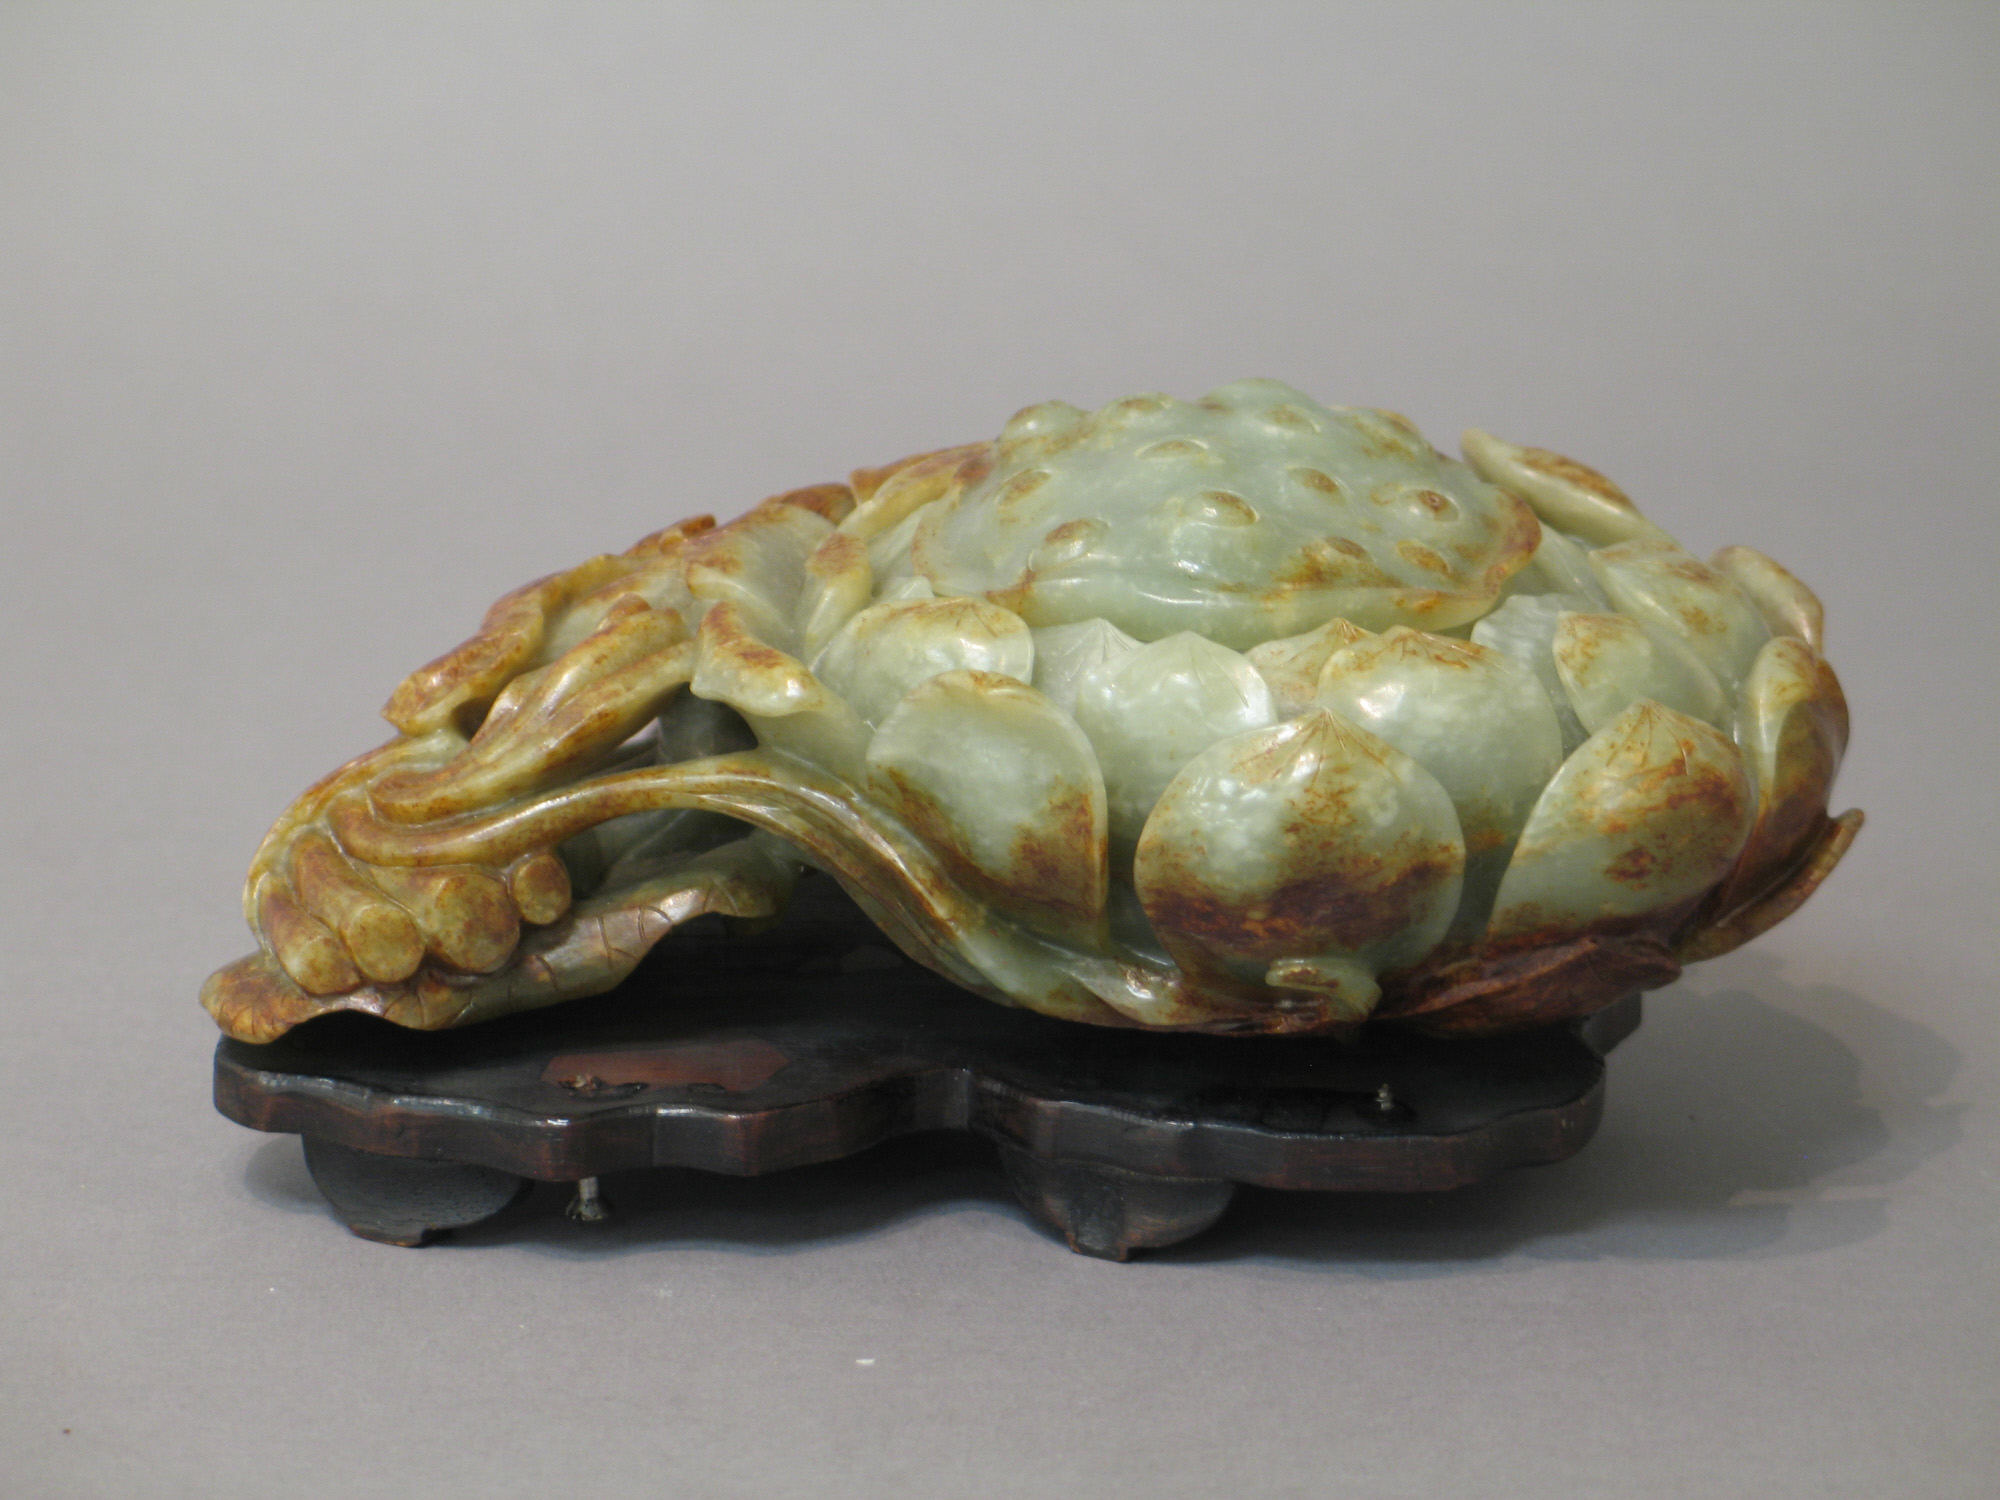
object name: water receptacle with cover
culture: chinese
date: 1368-1644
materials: jade, wood